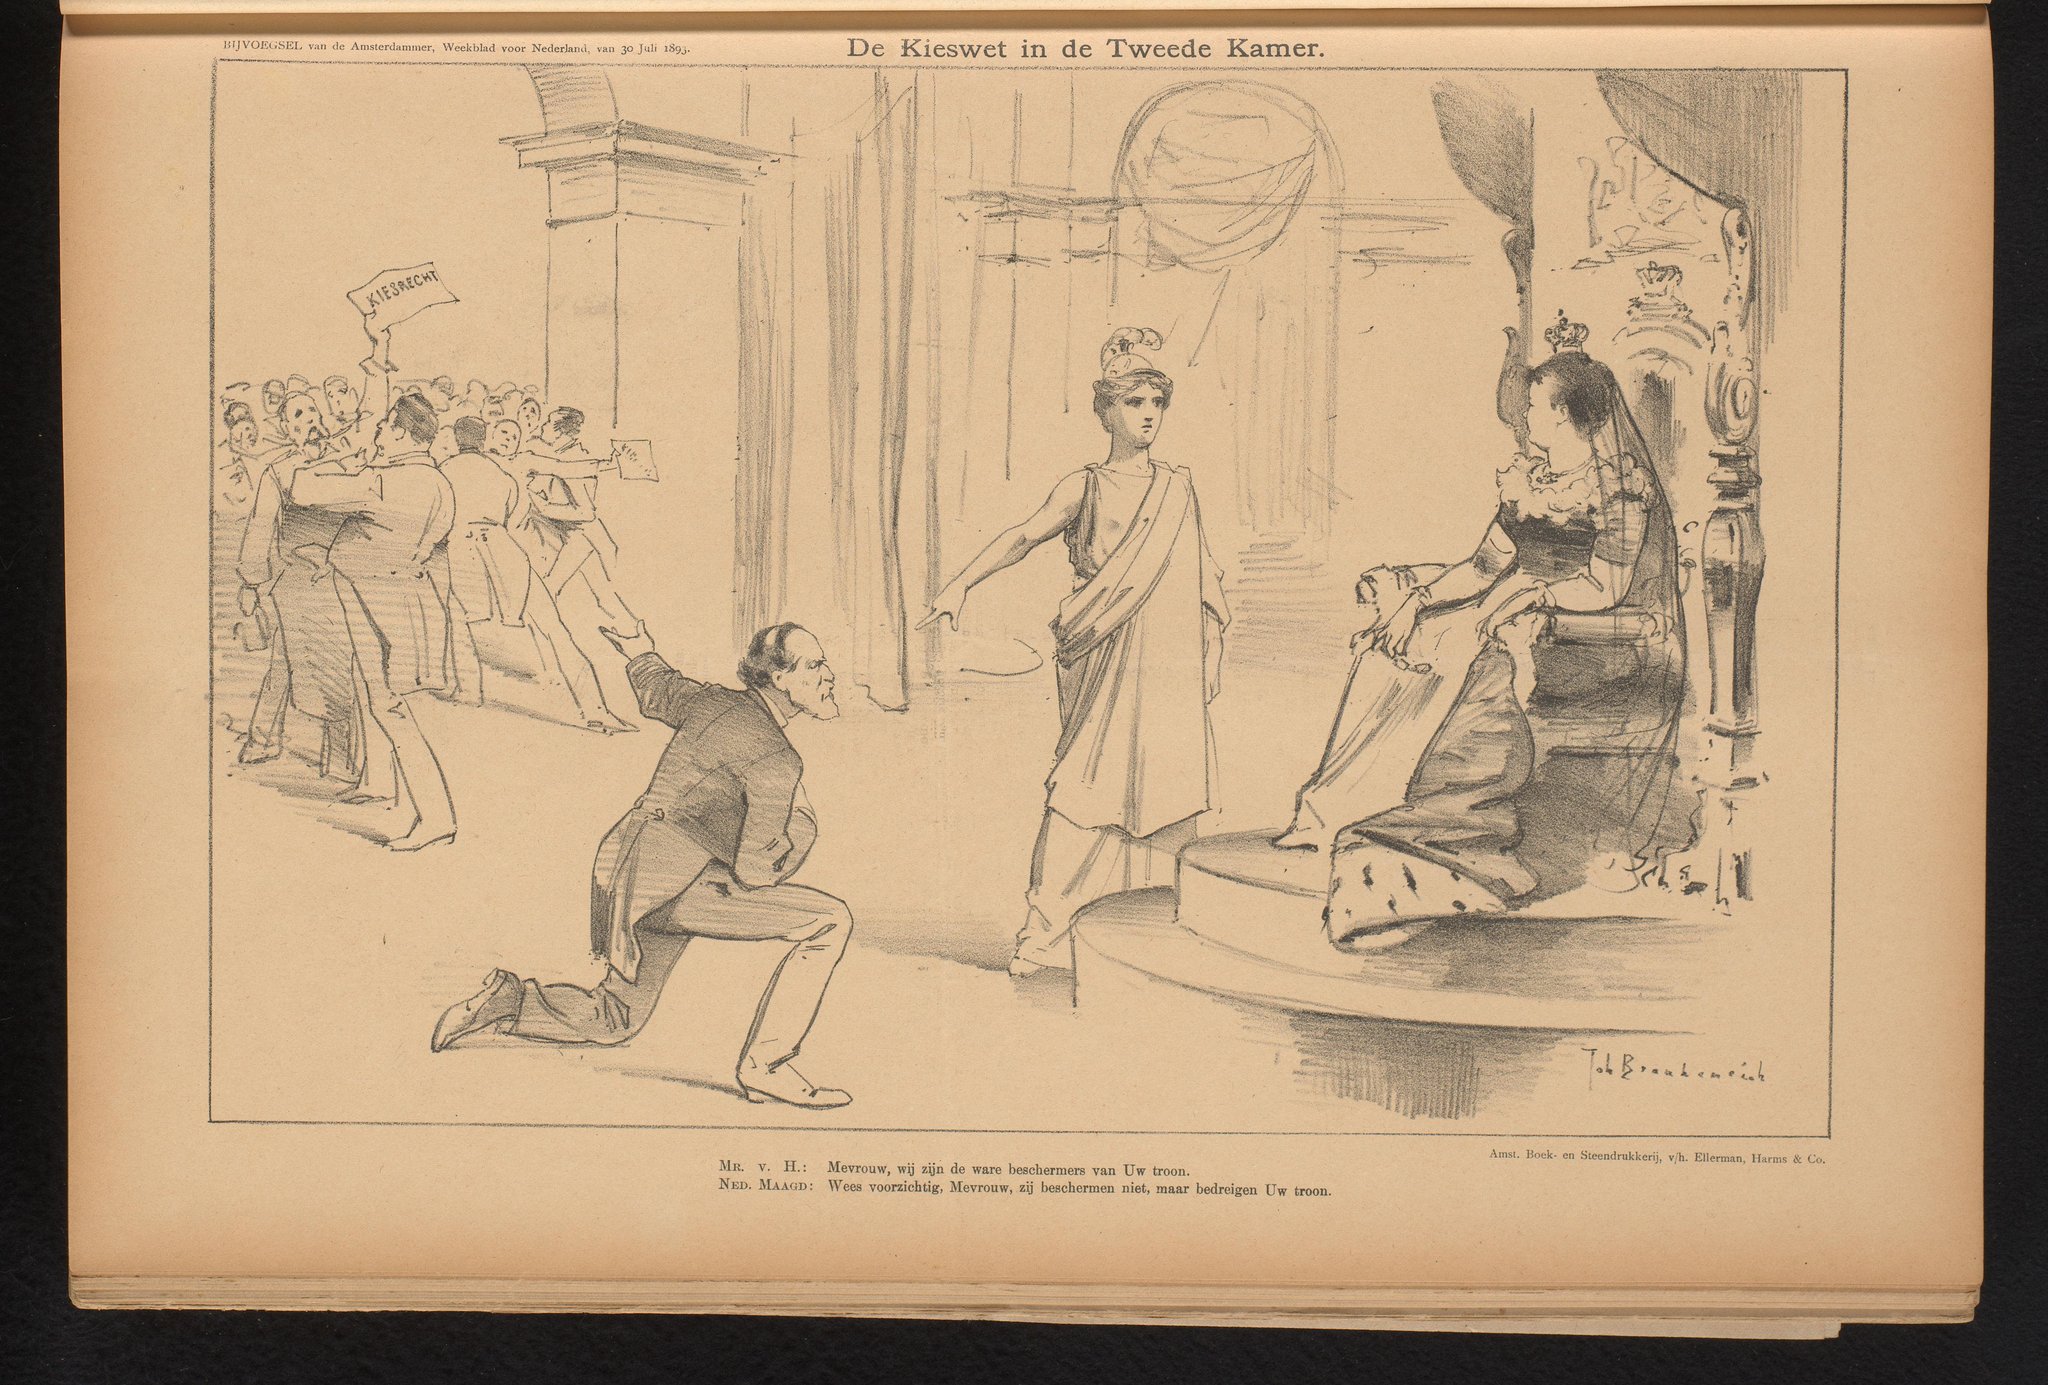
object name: cartoon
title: De Kieswet in de Tweede Kamer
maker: johan braakensiek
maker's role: draughtsman, print maker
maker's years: 1858-1940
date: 1893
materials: paper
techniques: lithograph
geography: netherlands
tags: print maker, wilhelmina of the netherlands, the hague, politician, samuel van houten, personifications of countries, nations, states, districts, etc., the right to vote, the compulsory vote, political caricatures and satires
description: Kamerlid Samuel van Houten knielt voor koningin Wilhelmina en geeft aan haar troon te willen beschermen tegen een groep Kamerleden die pleiten voor kiesrecht in de Tweede Kamer. De Nederlandse Maagd spreekt dit tegen.